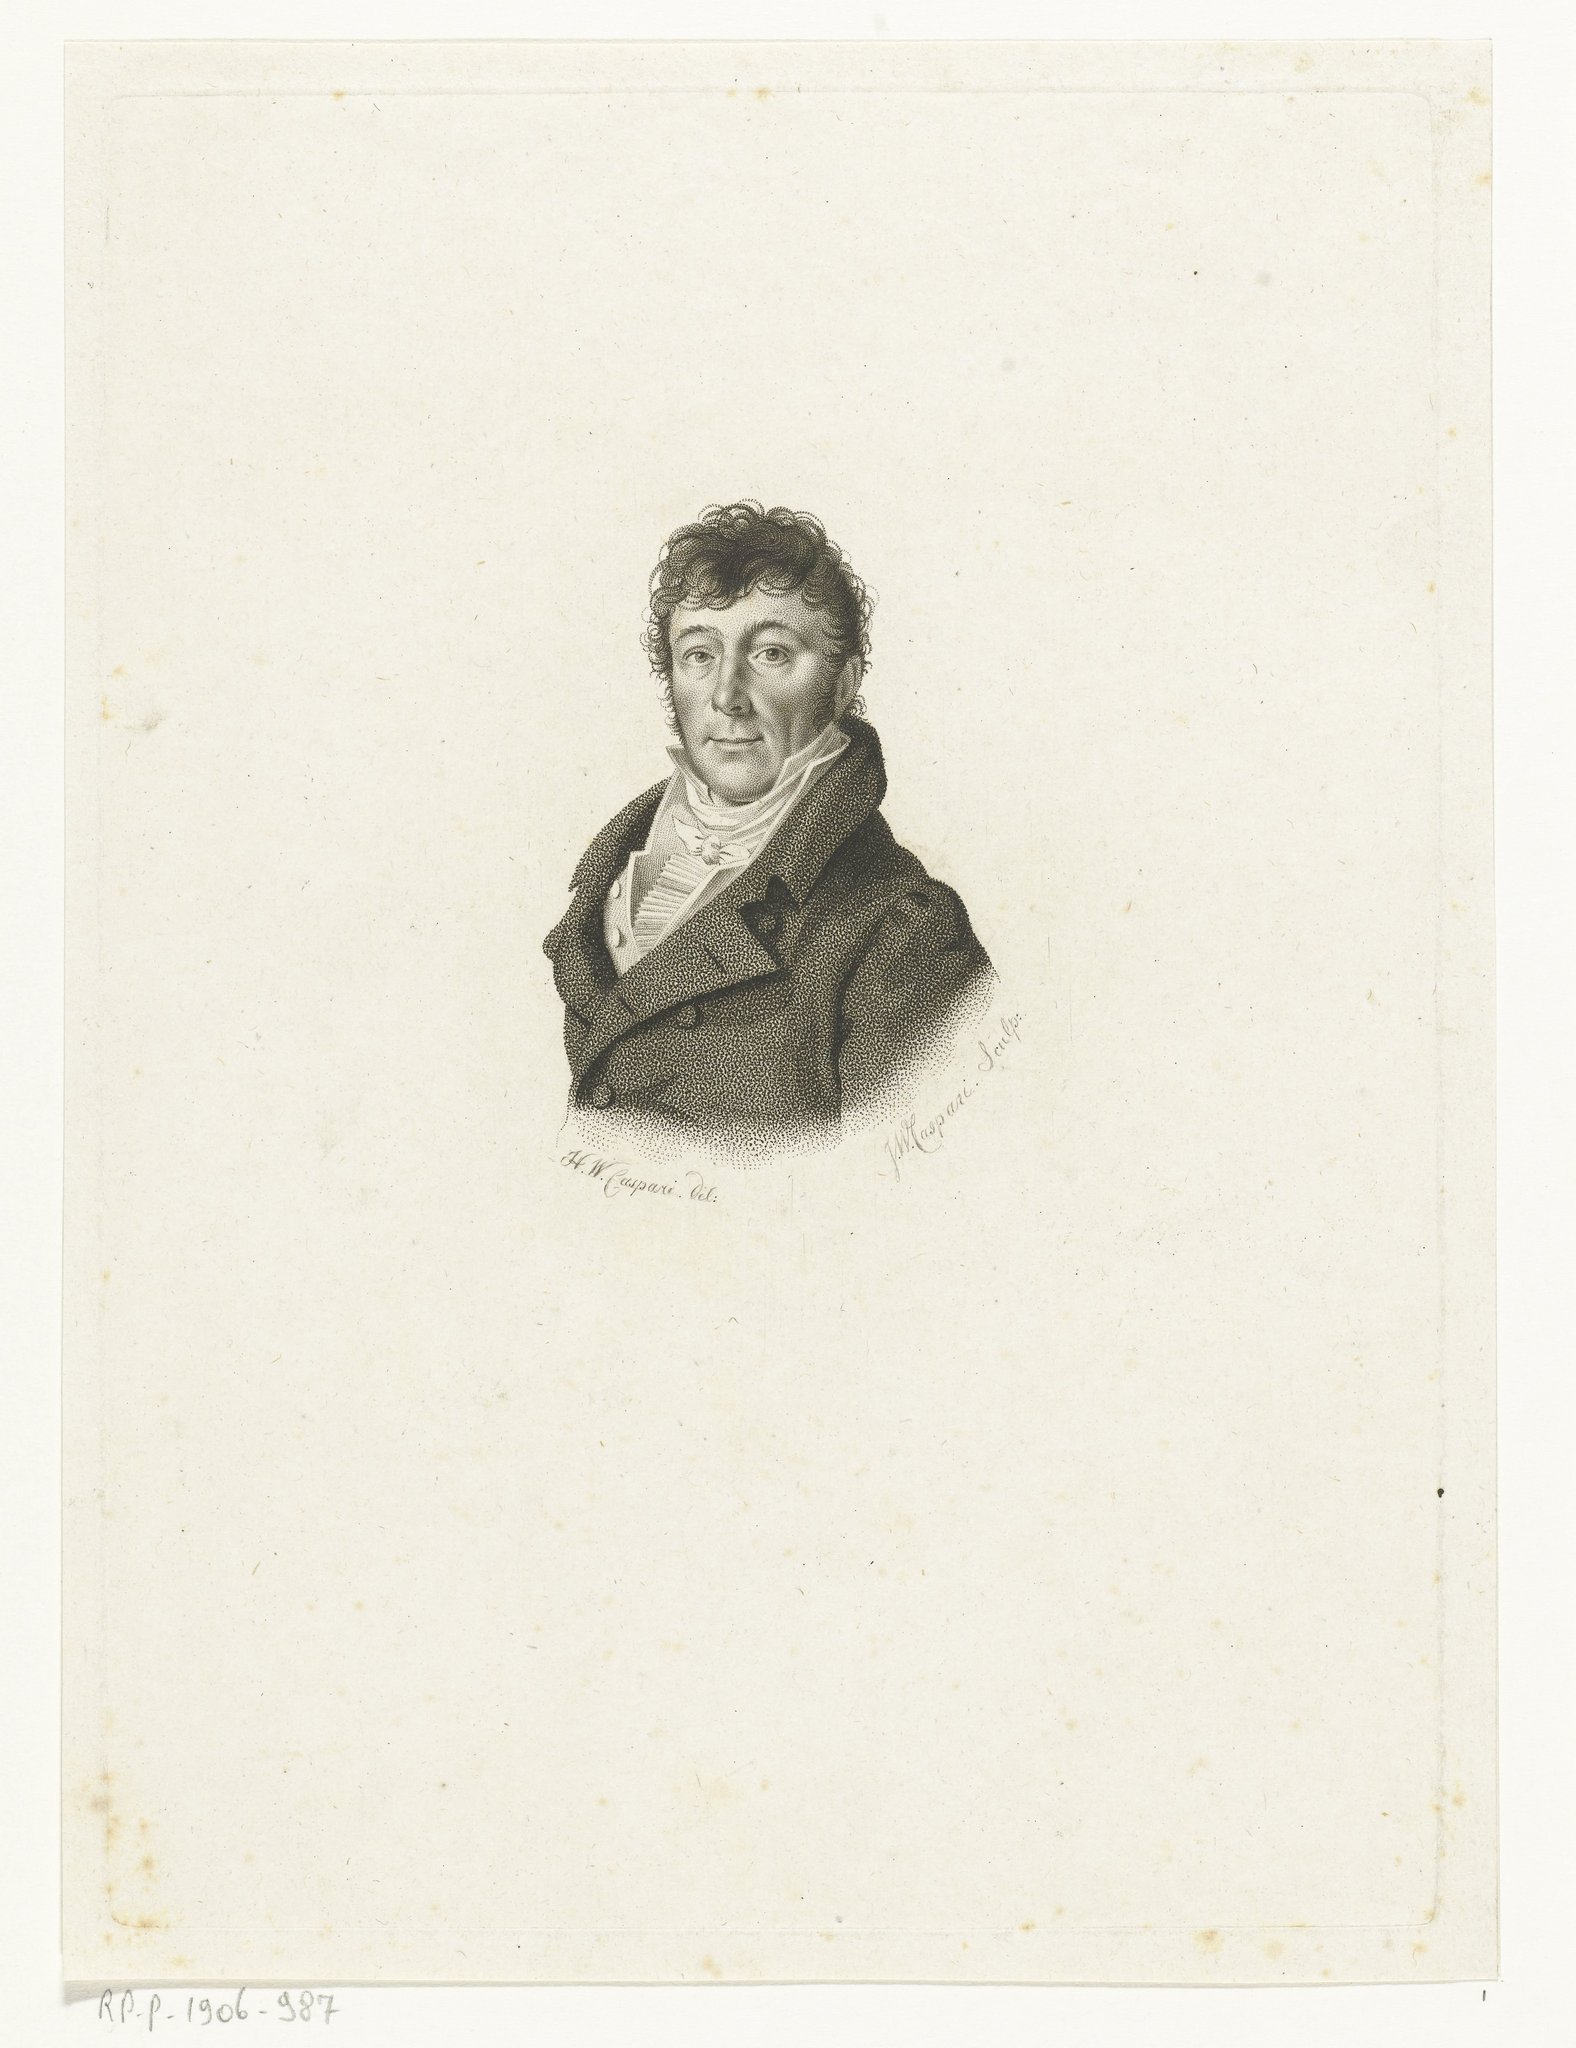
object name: print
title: Portret van Bernardus Antonius Fallee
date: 1789-1822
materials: paper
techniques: etching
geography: amsterdam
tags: the hague, bernard anthonie fallée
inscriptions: collector's mark: Lugt 2228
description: Portret van Bernardus Antonius Fallee, een Nederlandse toneelschrijver. Buste naar links. Fallee heeft een zwarte jas aan met een hoge kraag.